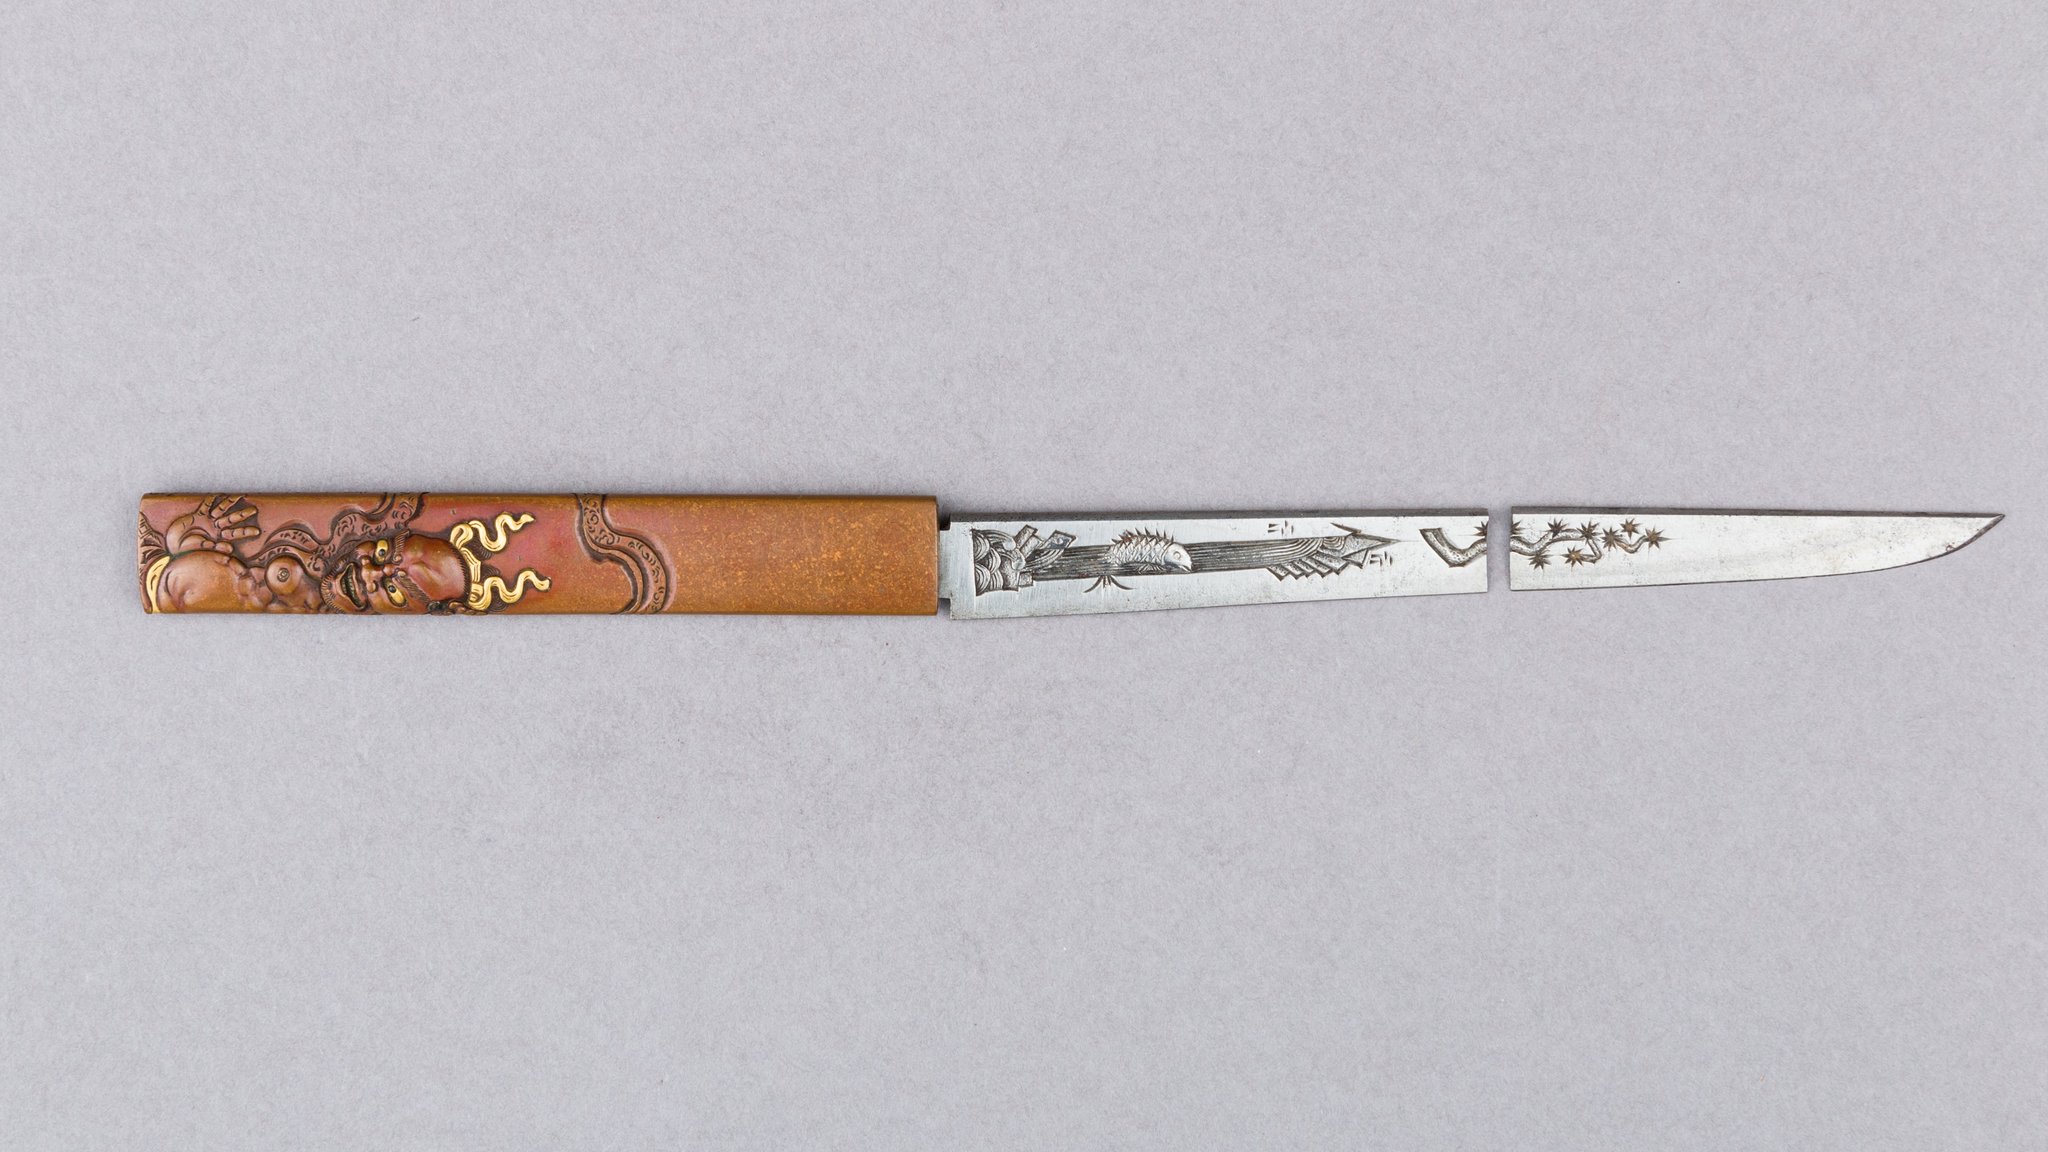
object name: knife handle kozuka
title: Knife Handle (Kozuka) with Blade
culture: japanese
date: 1701-1800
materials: copper, silver alloy, gold, steel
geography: japan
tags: men,fish